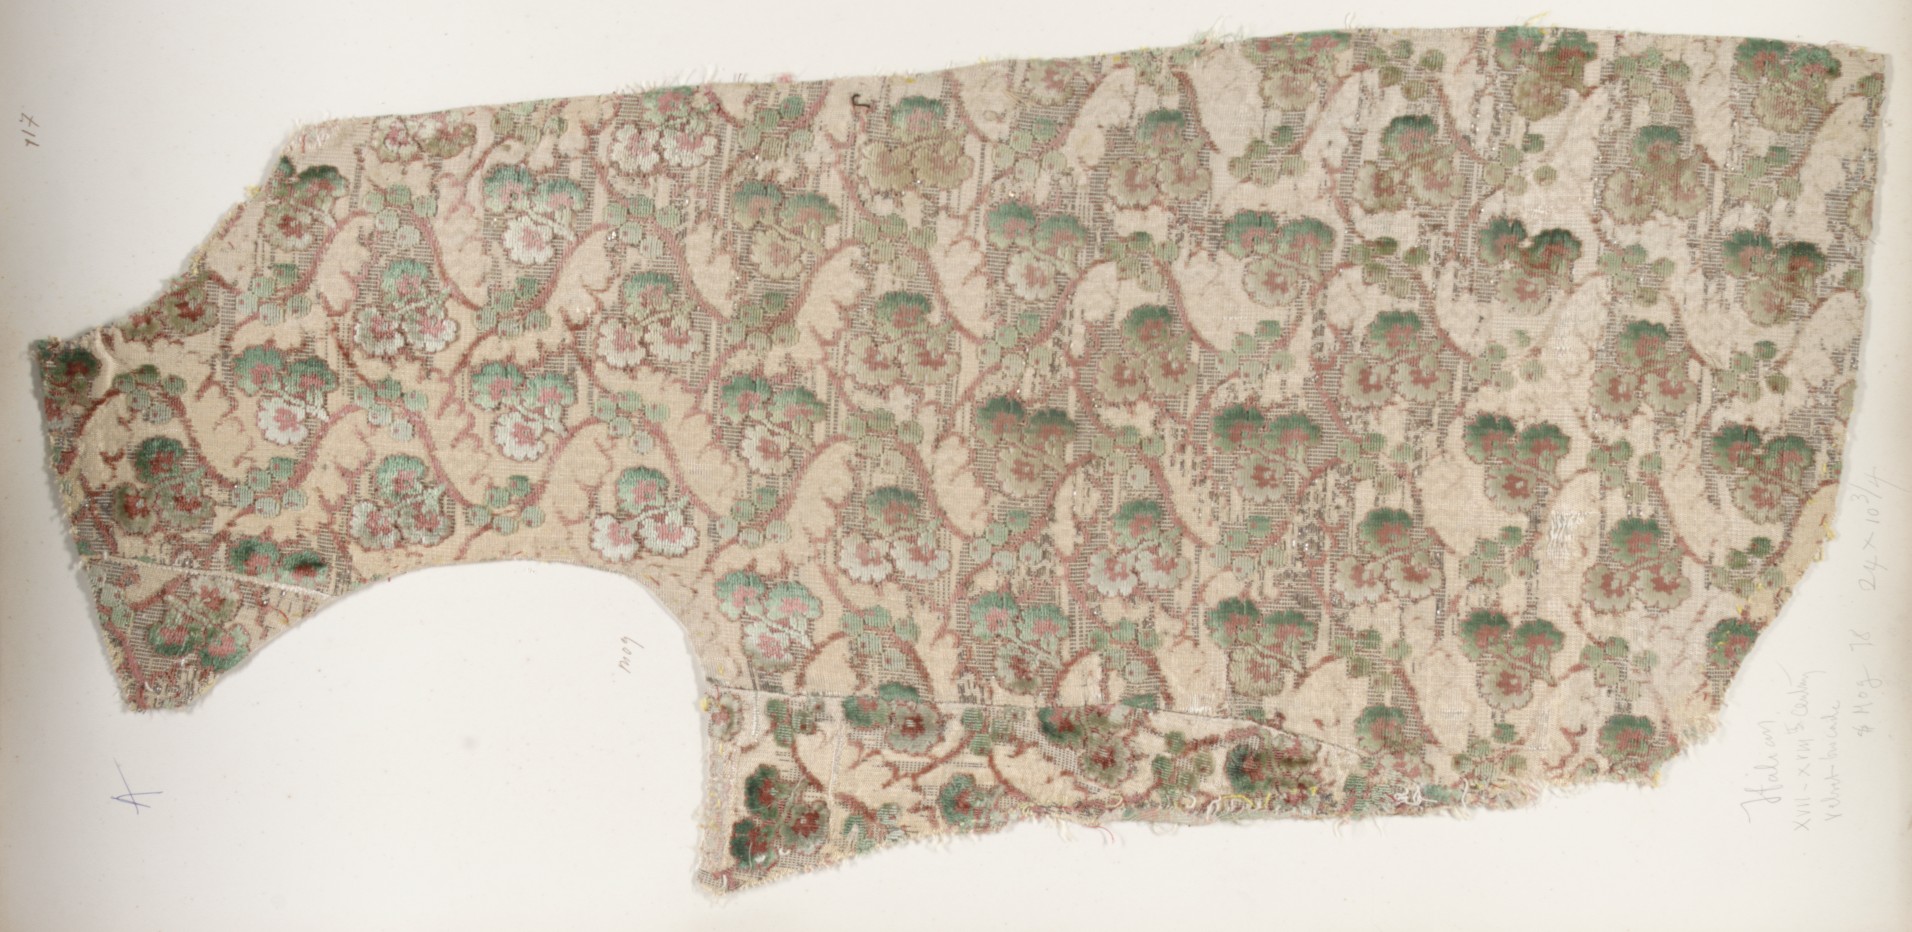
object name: fragment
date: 1701-1800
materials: metal thread, silk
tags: flowers